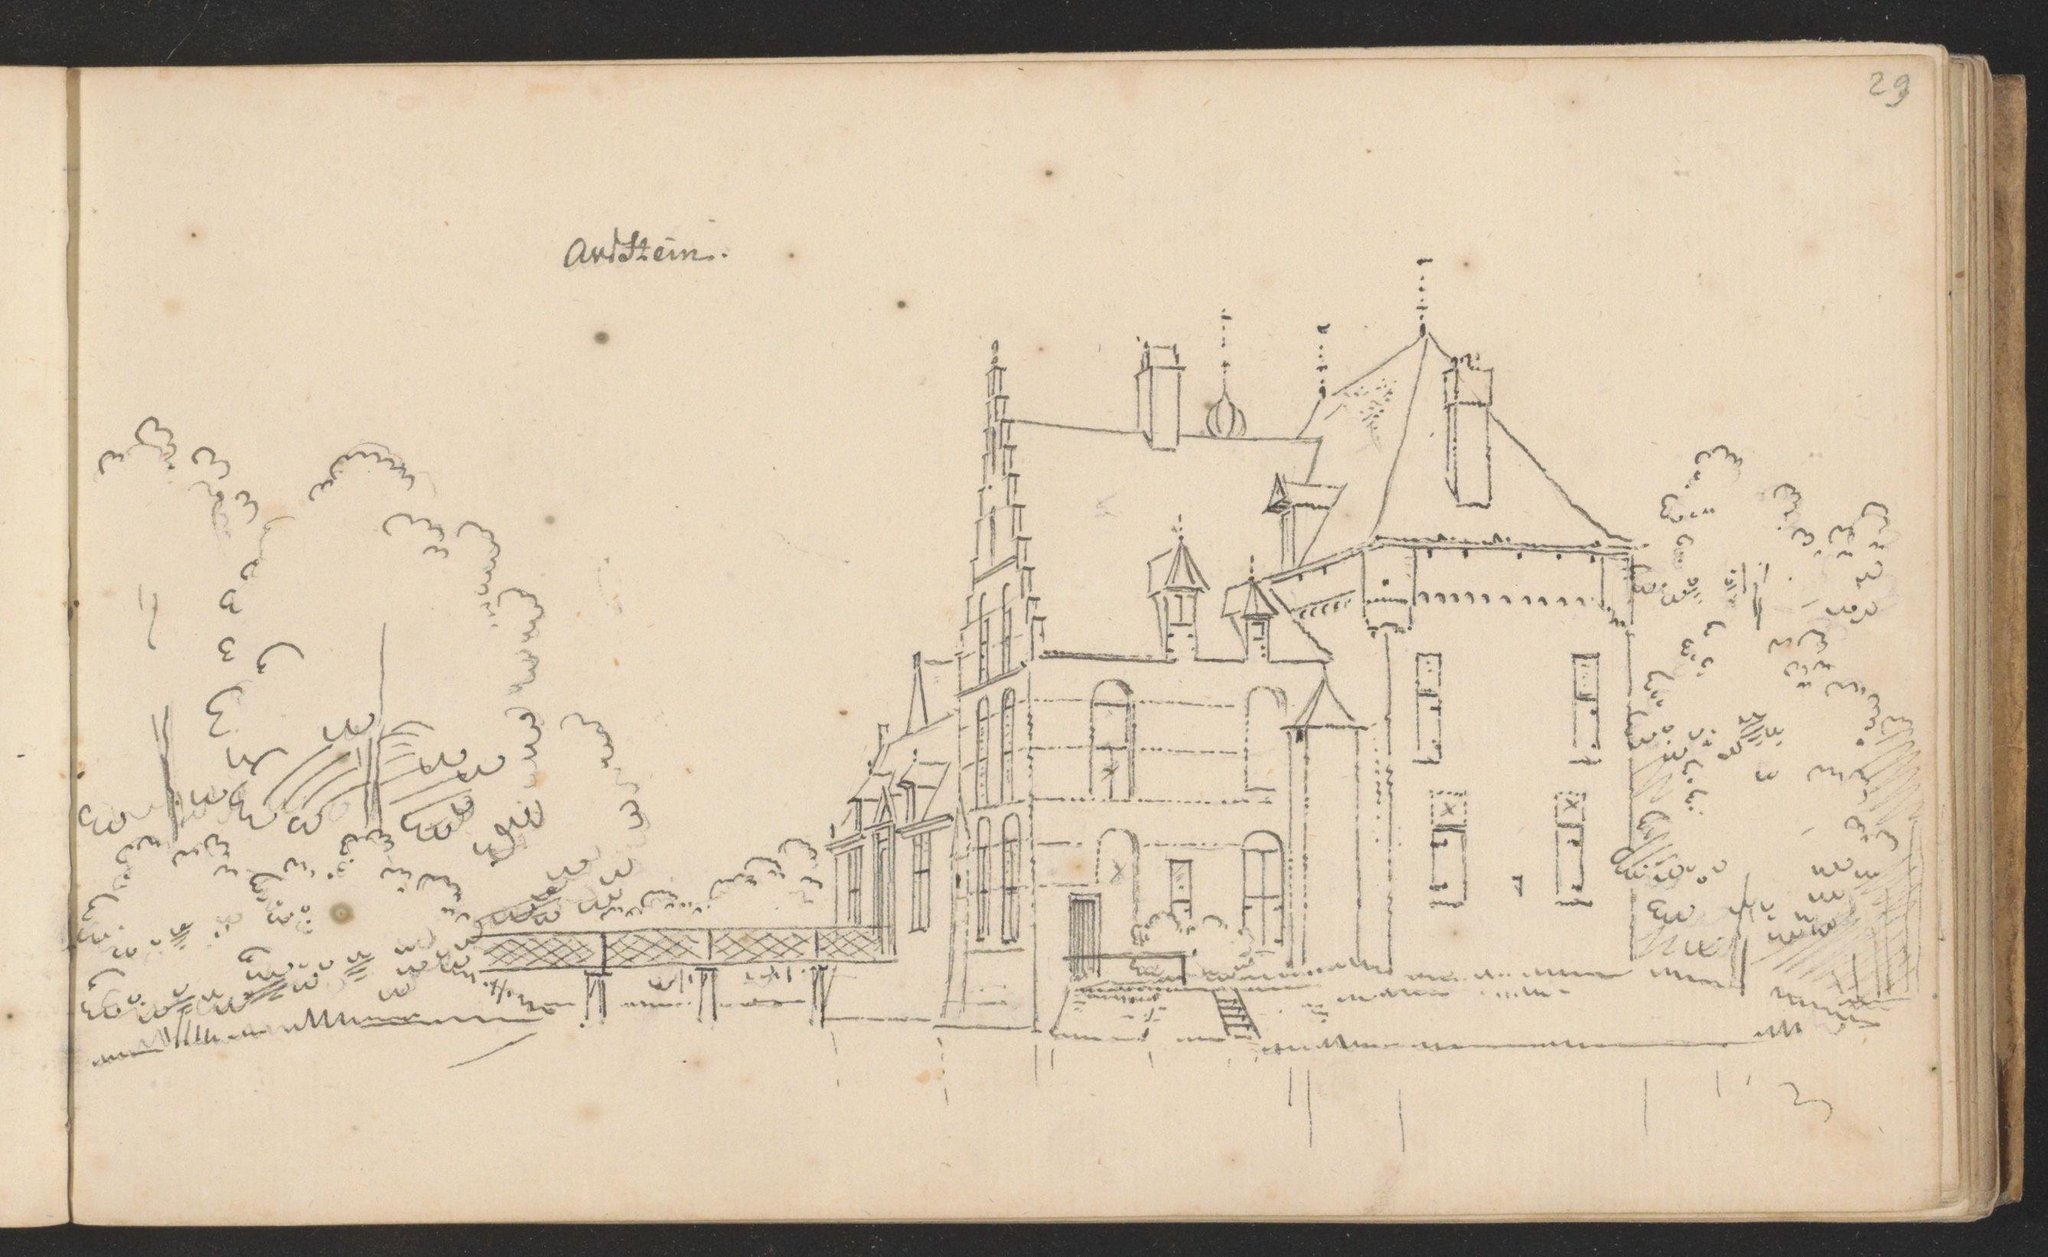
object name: sketchbook leaf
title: Kasteel Avestein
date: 1701-1759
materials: ink, paper, pencil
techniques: pen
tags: castle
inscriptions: annotation: ‘Avestein’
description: Blad 29 recto uit een schetsboek met 65 bladen.